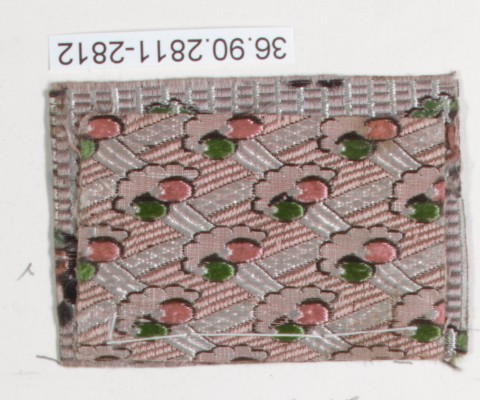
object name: piece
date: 1801-1900